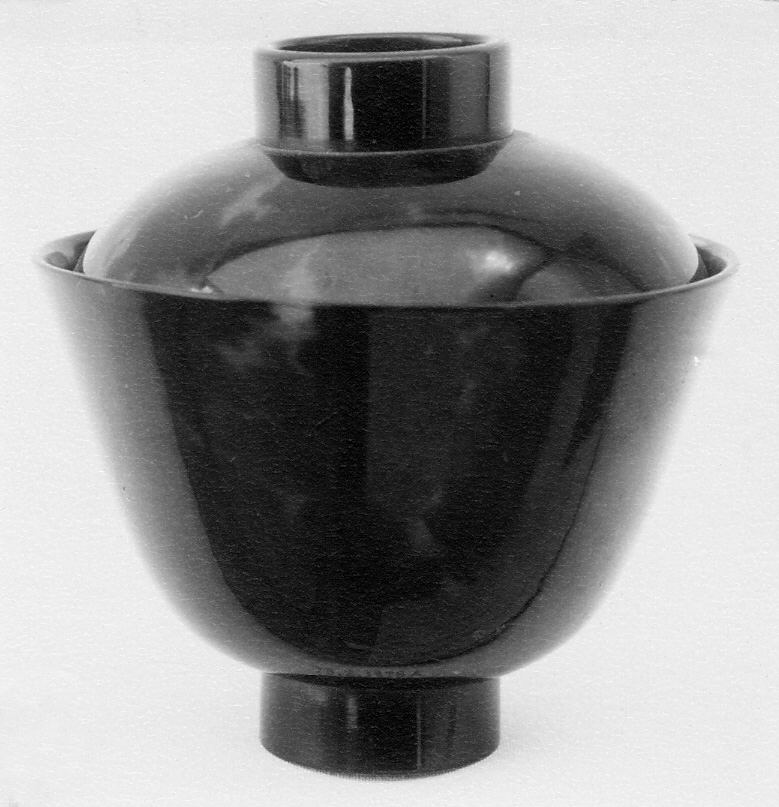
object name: cup with cover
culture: chinese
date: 1801-1900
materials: shell